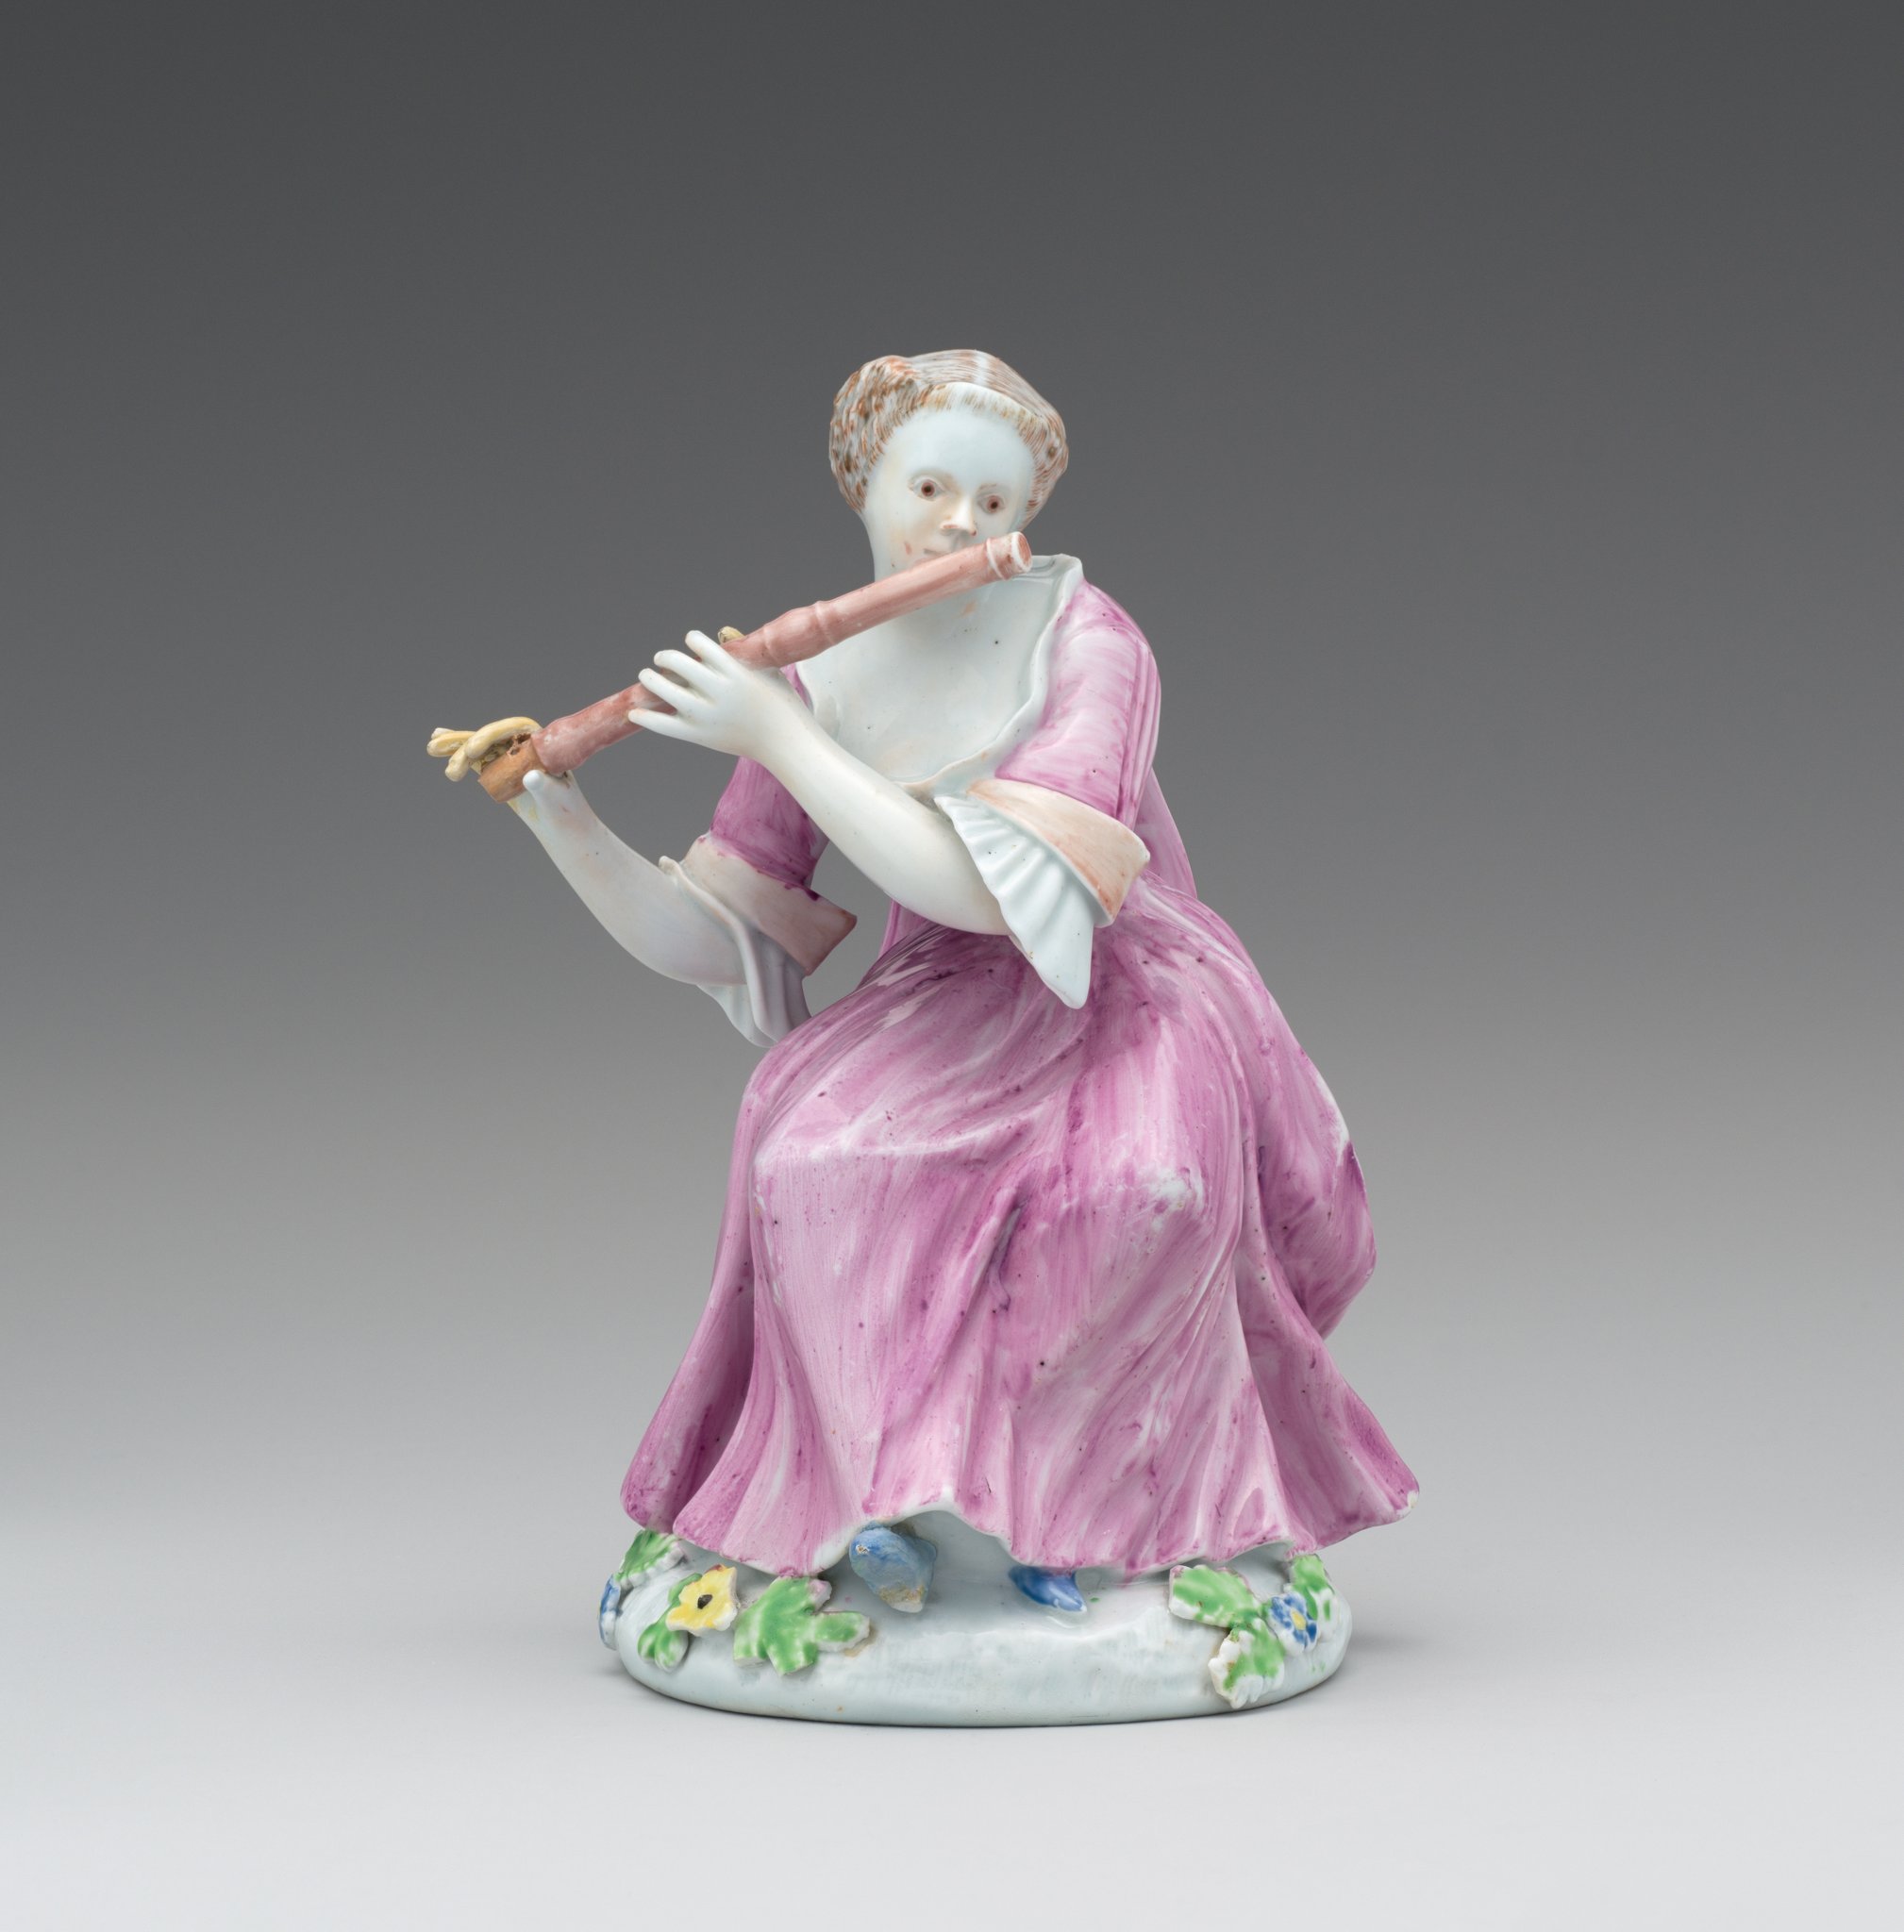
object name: figure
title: Woman with a flute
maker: longton hall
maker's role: factory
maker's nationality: british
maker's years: 1744-1760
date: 1755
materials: soft paste porcelain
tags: women,flutes